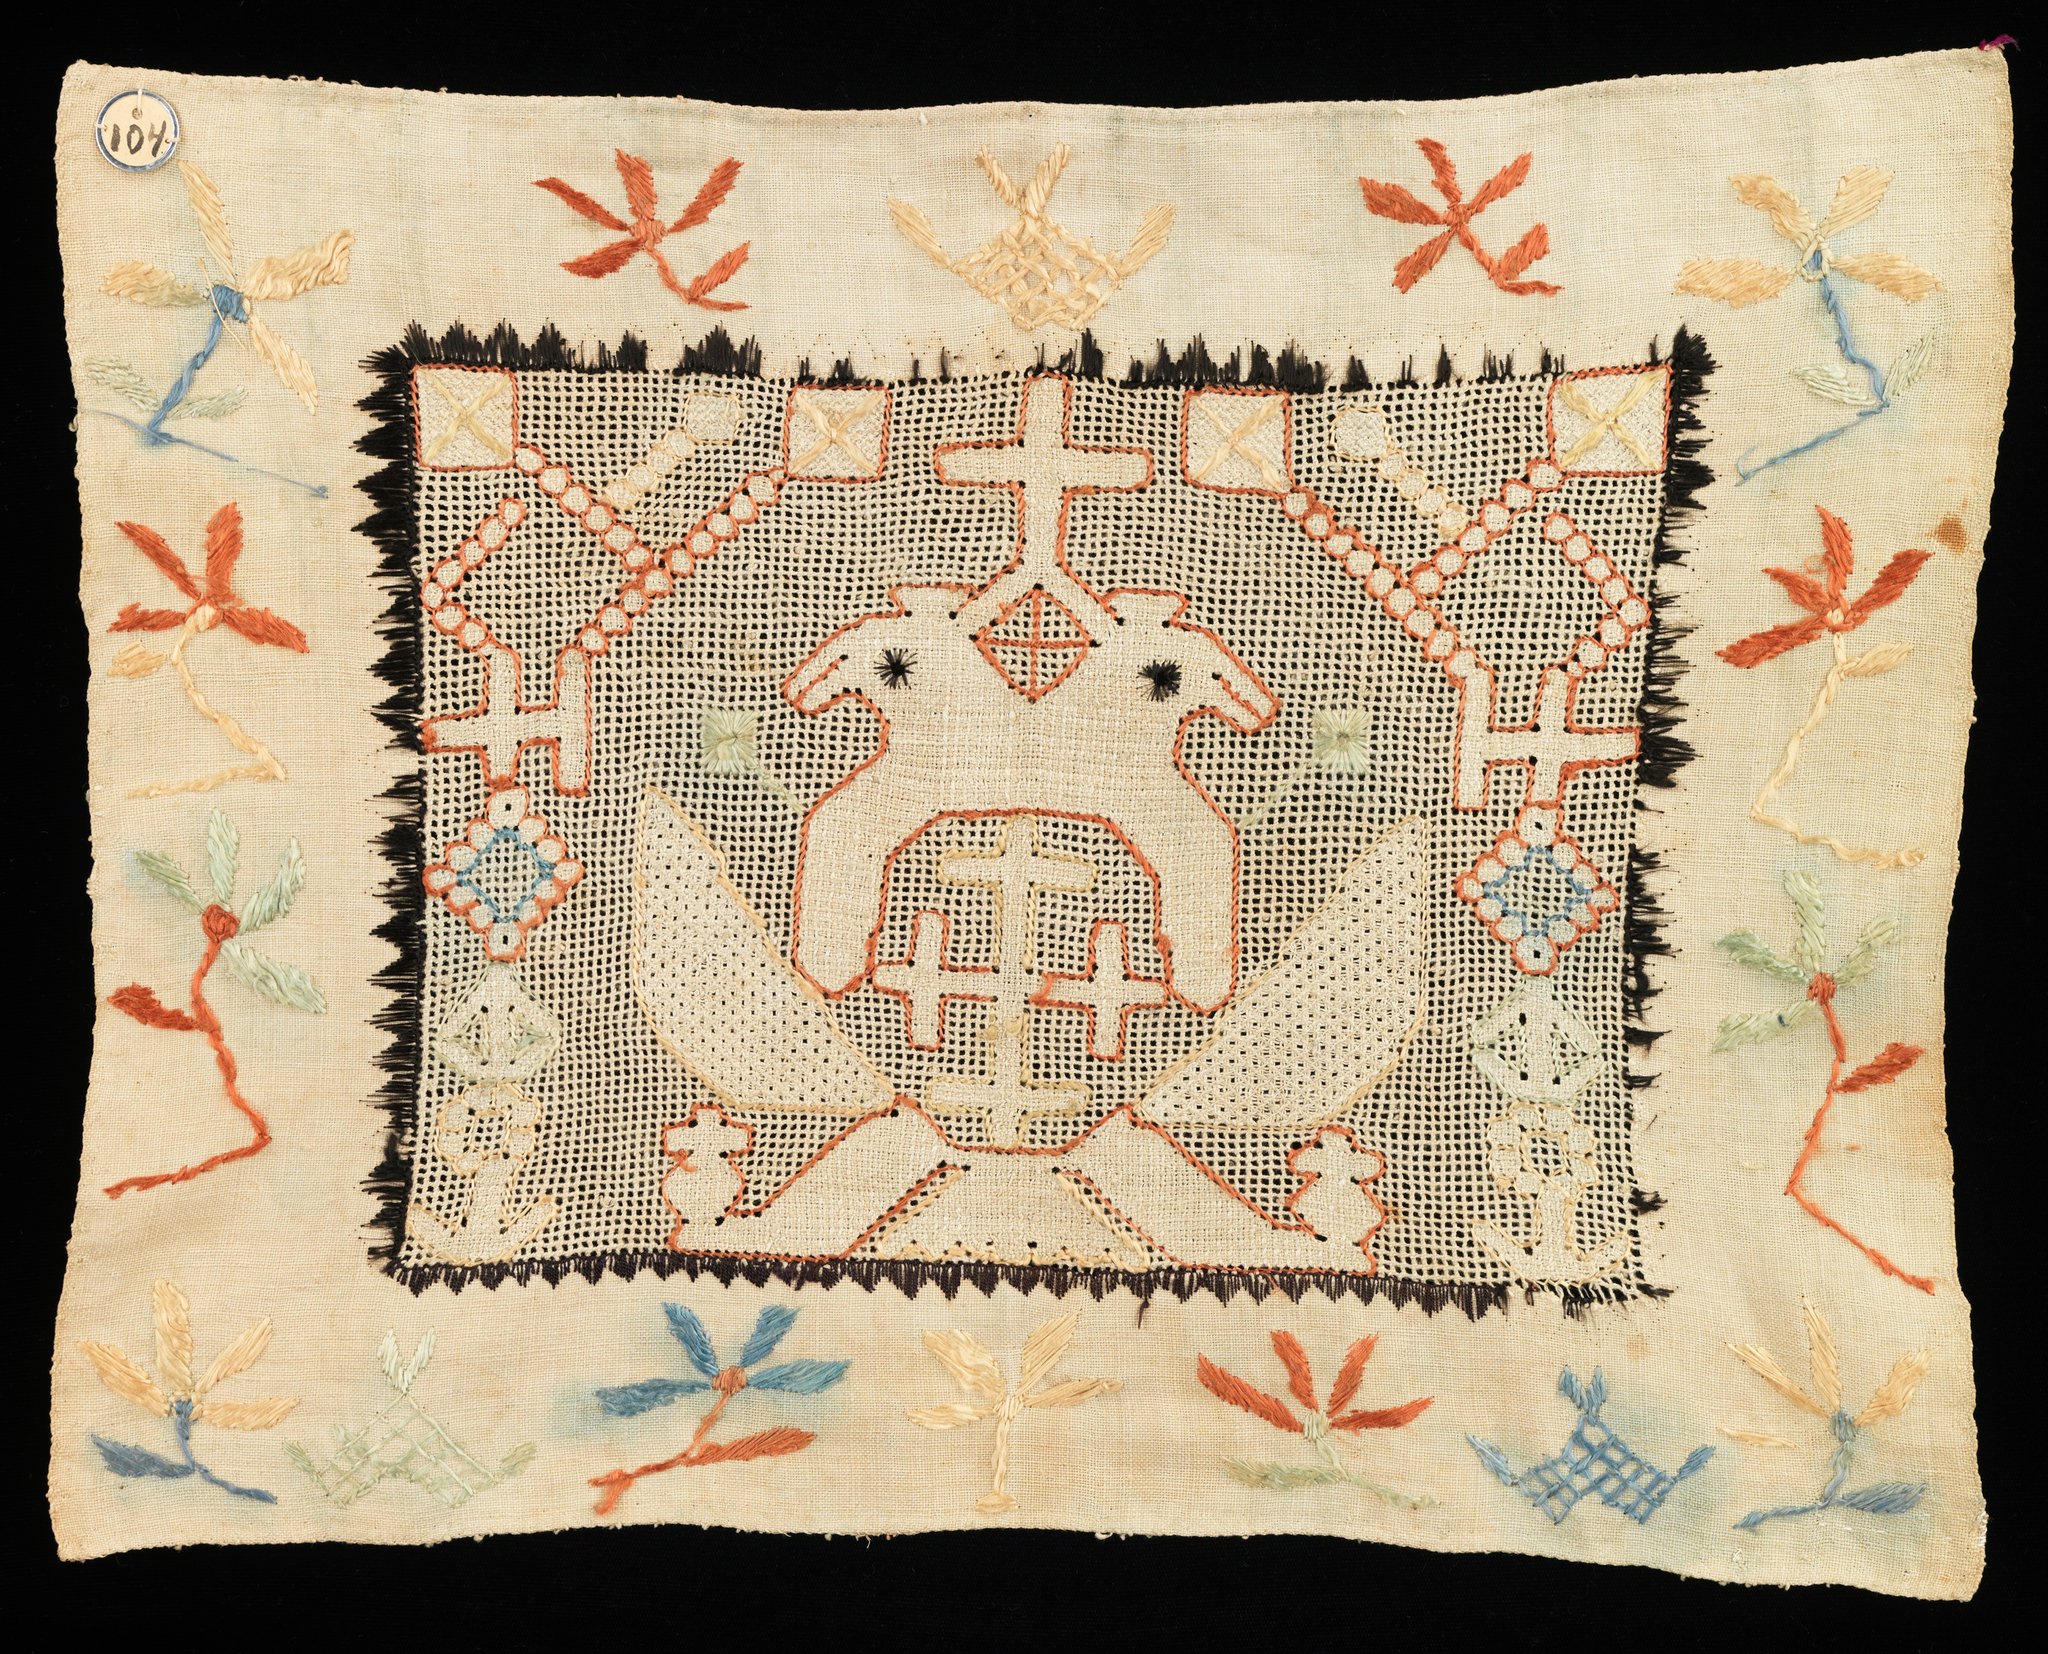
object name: border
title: Towel border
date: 1780-1820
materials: linen, silk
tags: eagles